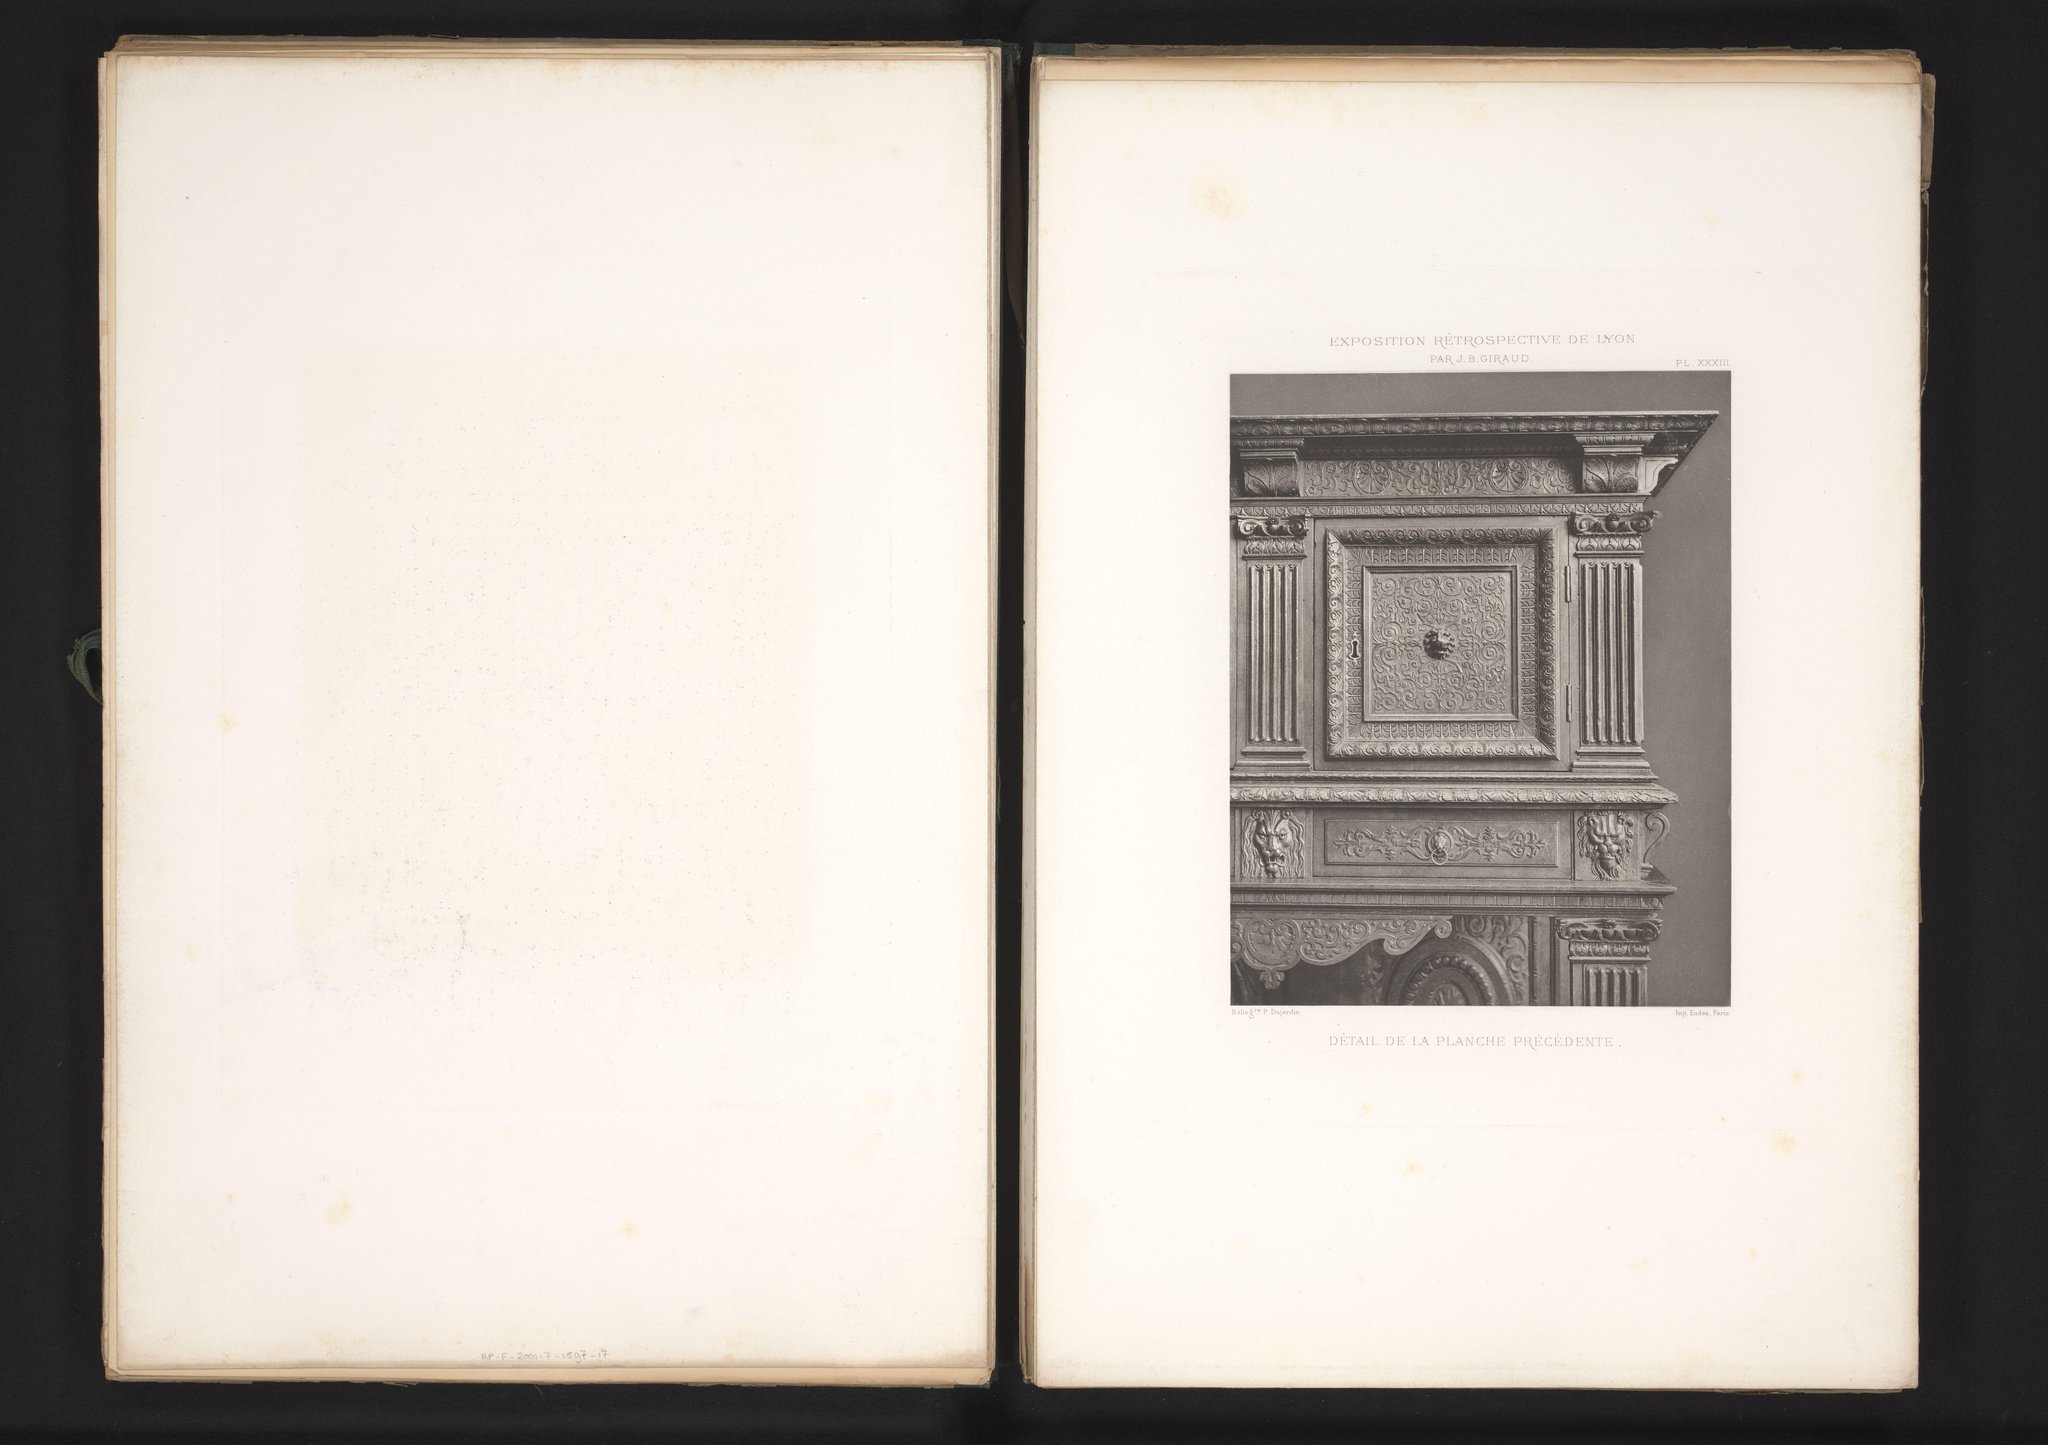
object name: photomechanical print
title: Detail van een 16de-eeuws Frans dressoir van hout, op de Exposition Rétrospective van 1877 in Lyon, Frankrijk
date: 1877-1878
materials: paper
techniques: photoaquatint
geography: paris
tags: ornamental cupboard (+ wood and other phytogenic material), lyon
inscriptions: number: ‘PL. XXXIII.’, inscription: ‘DÉTAIL DE LA PLANCHE PRÉCÉDENTE.’, inscription: ‘EXPOSITION RÉTROSPECTIVE DE LYON/ PAR J. B. GIRAUD.’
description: Deze prent maakt deel uit van een omslag met 79 prenten op 54 bladen en 65 tekstbladen.